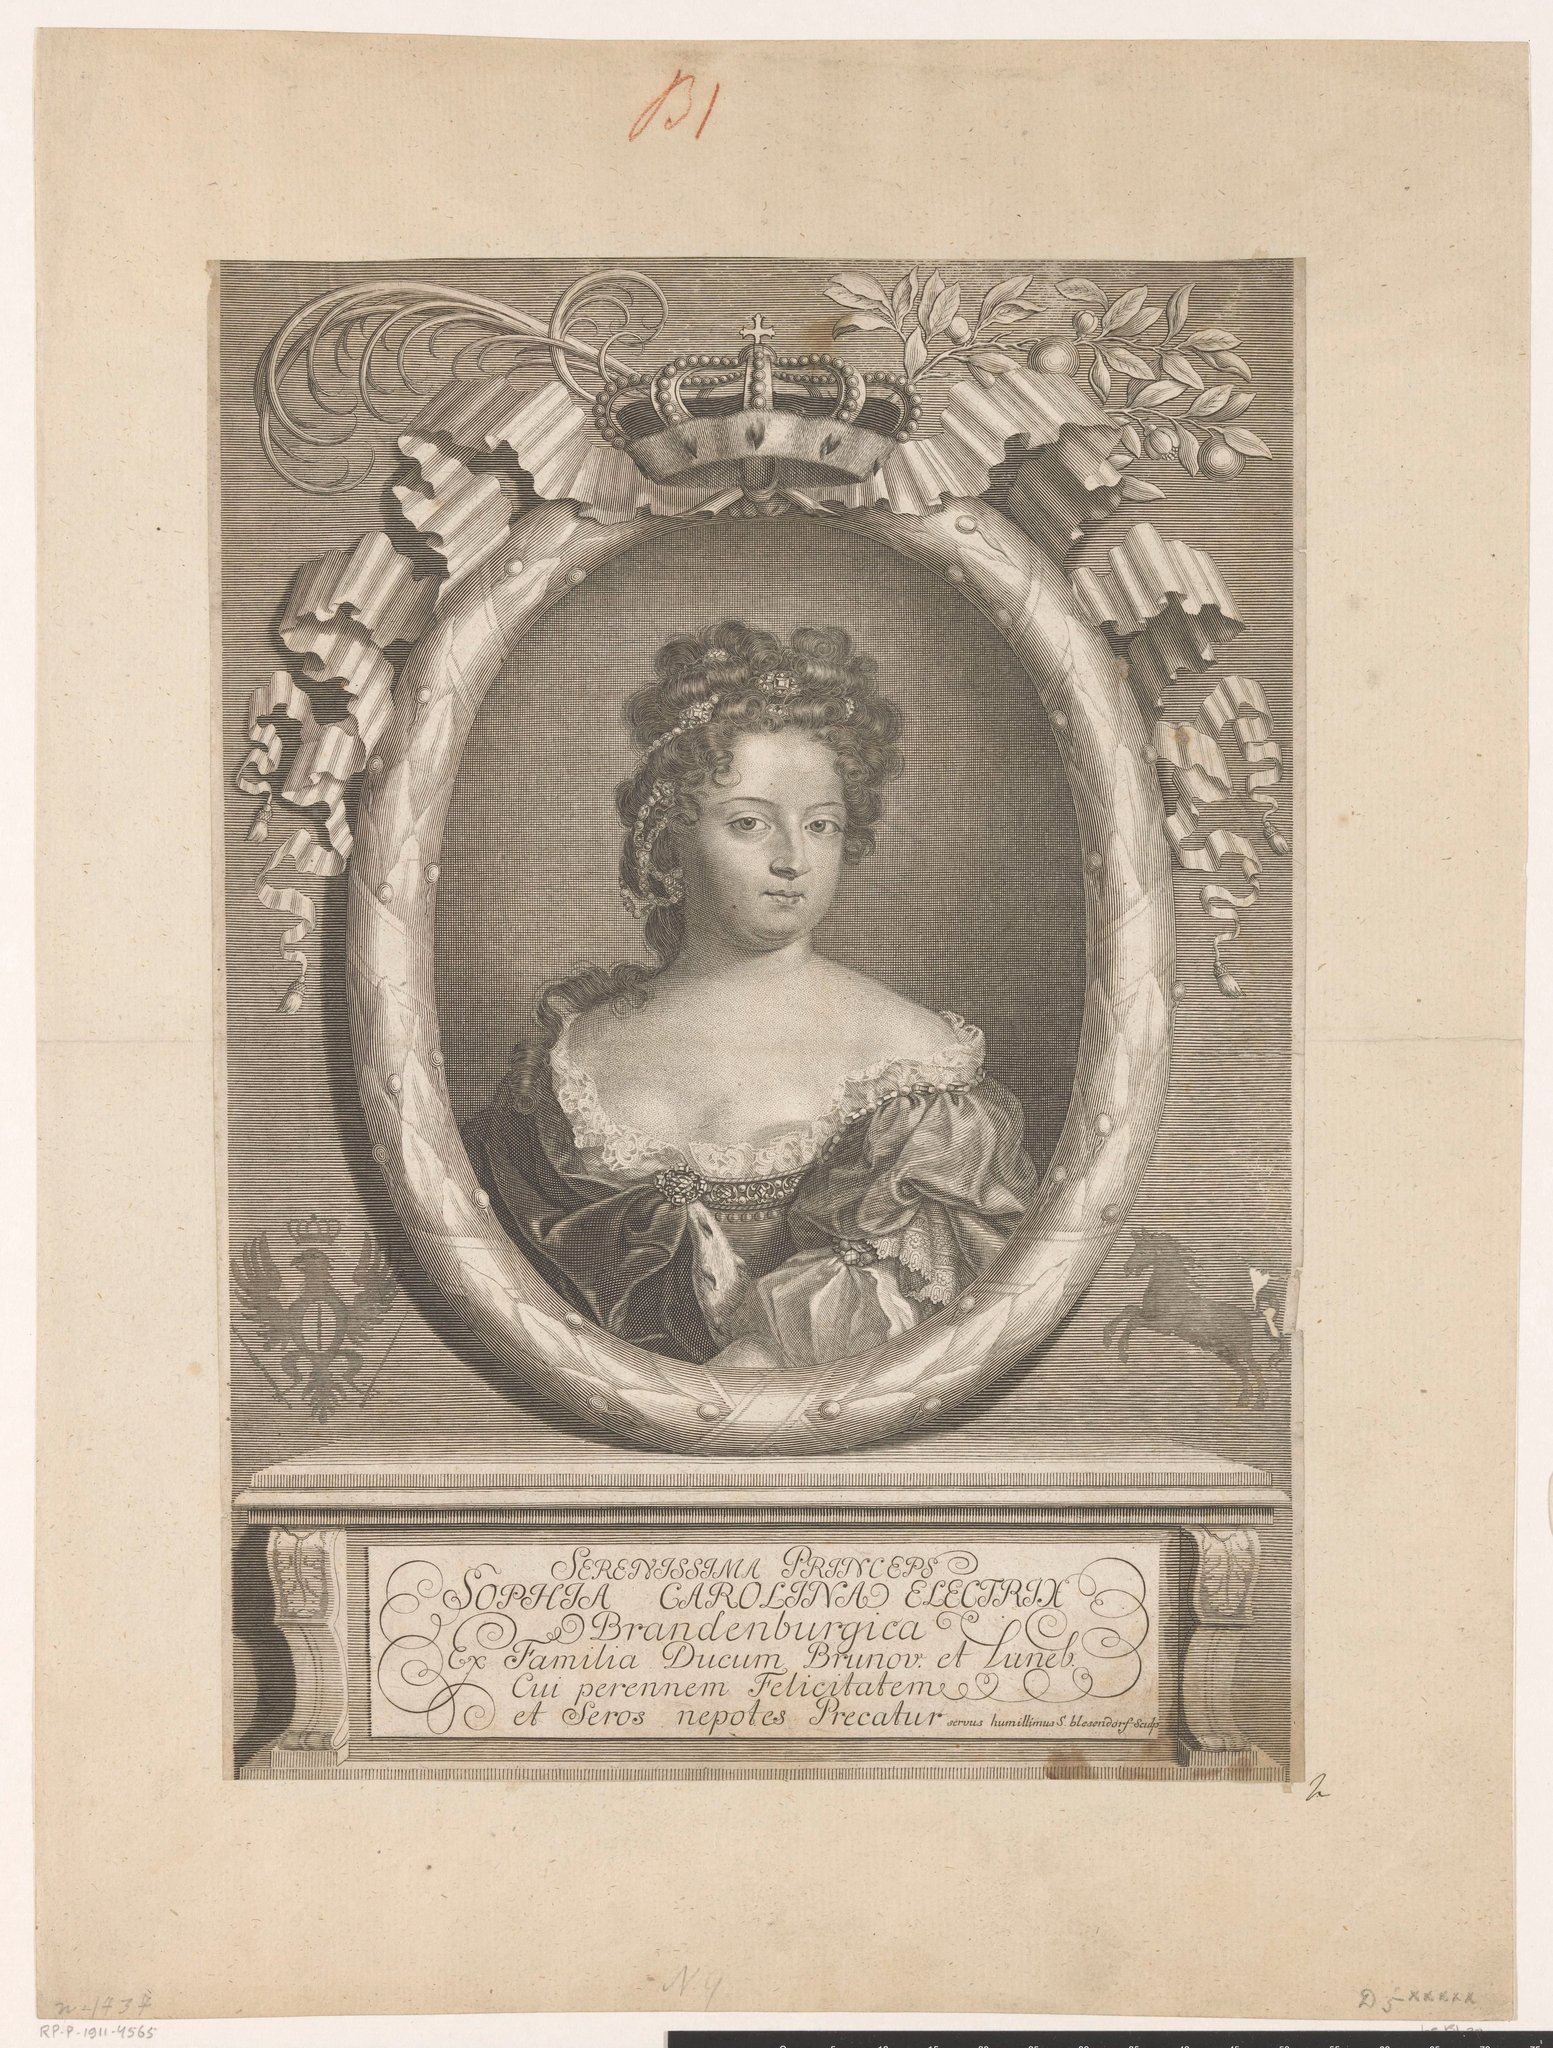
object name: print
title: Portret van Sophia Charlotte, koningin van Pruisen, als keurvorstin van Brandenburg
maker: samuel blesendorf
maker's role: painter, print maker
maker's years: 1633-1706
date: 1688-1701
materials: paper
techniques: engraving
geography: berlin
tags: berlin, crown (symbol of sovereignty), historical persons - bb - woman, ornaments, jewels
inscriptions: collector's mark: Lugt 2228